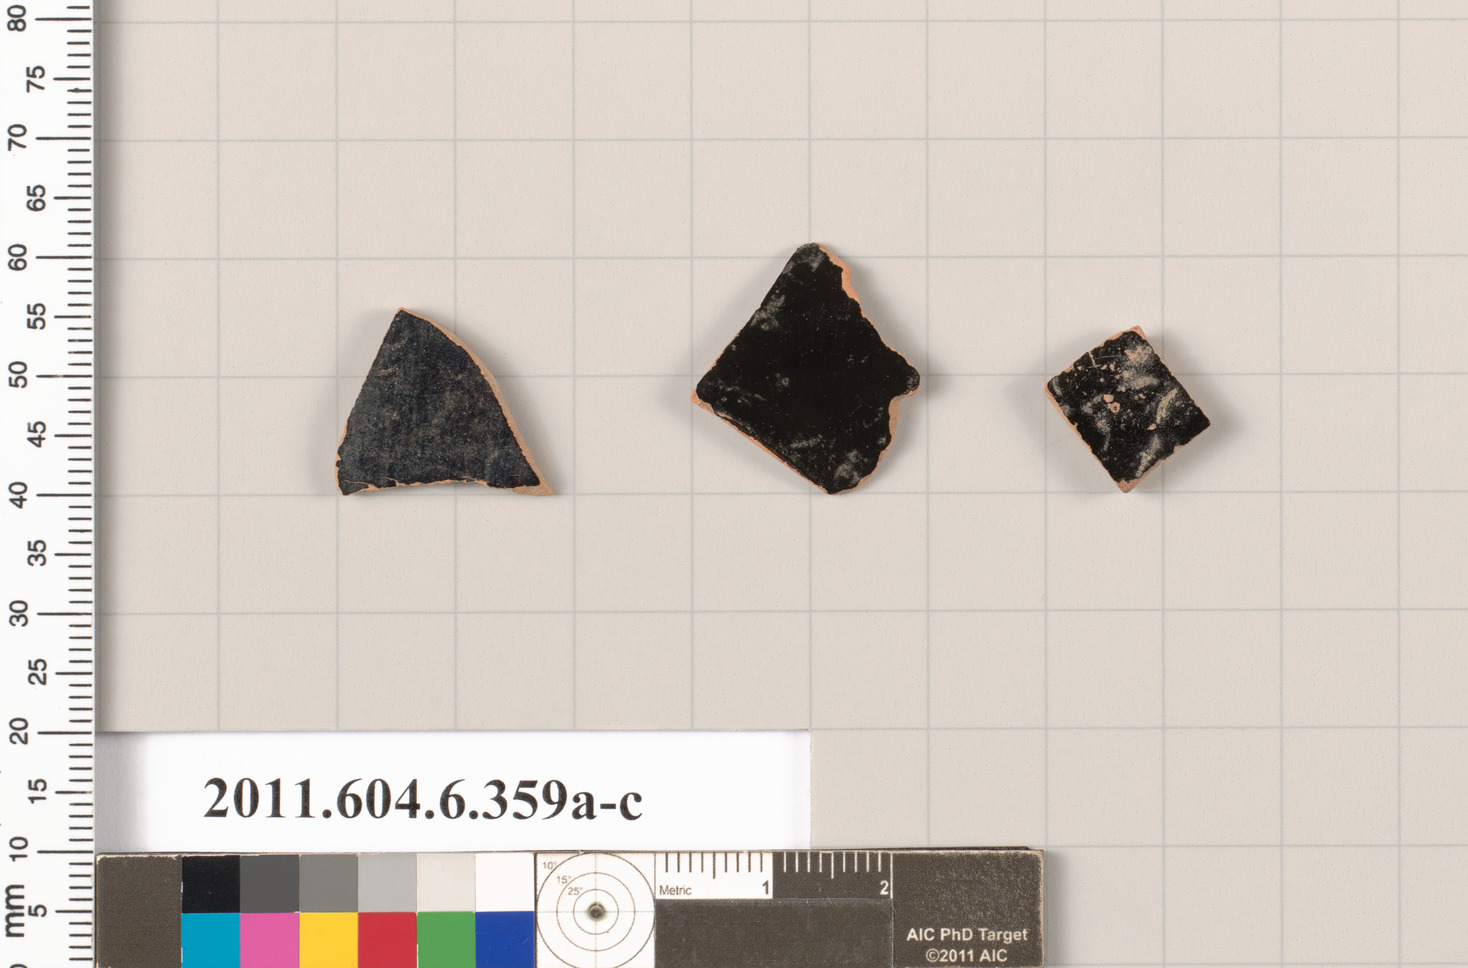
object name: undetermined closed shape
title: Terracotta fragments of closed shapes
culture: greek, attic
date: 600-401 BCE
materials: terracotta